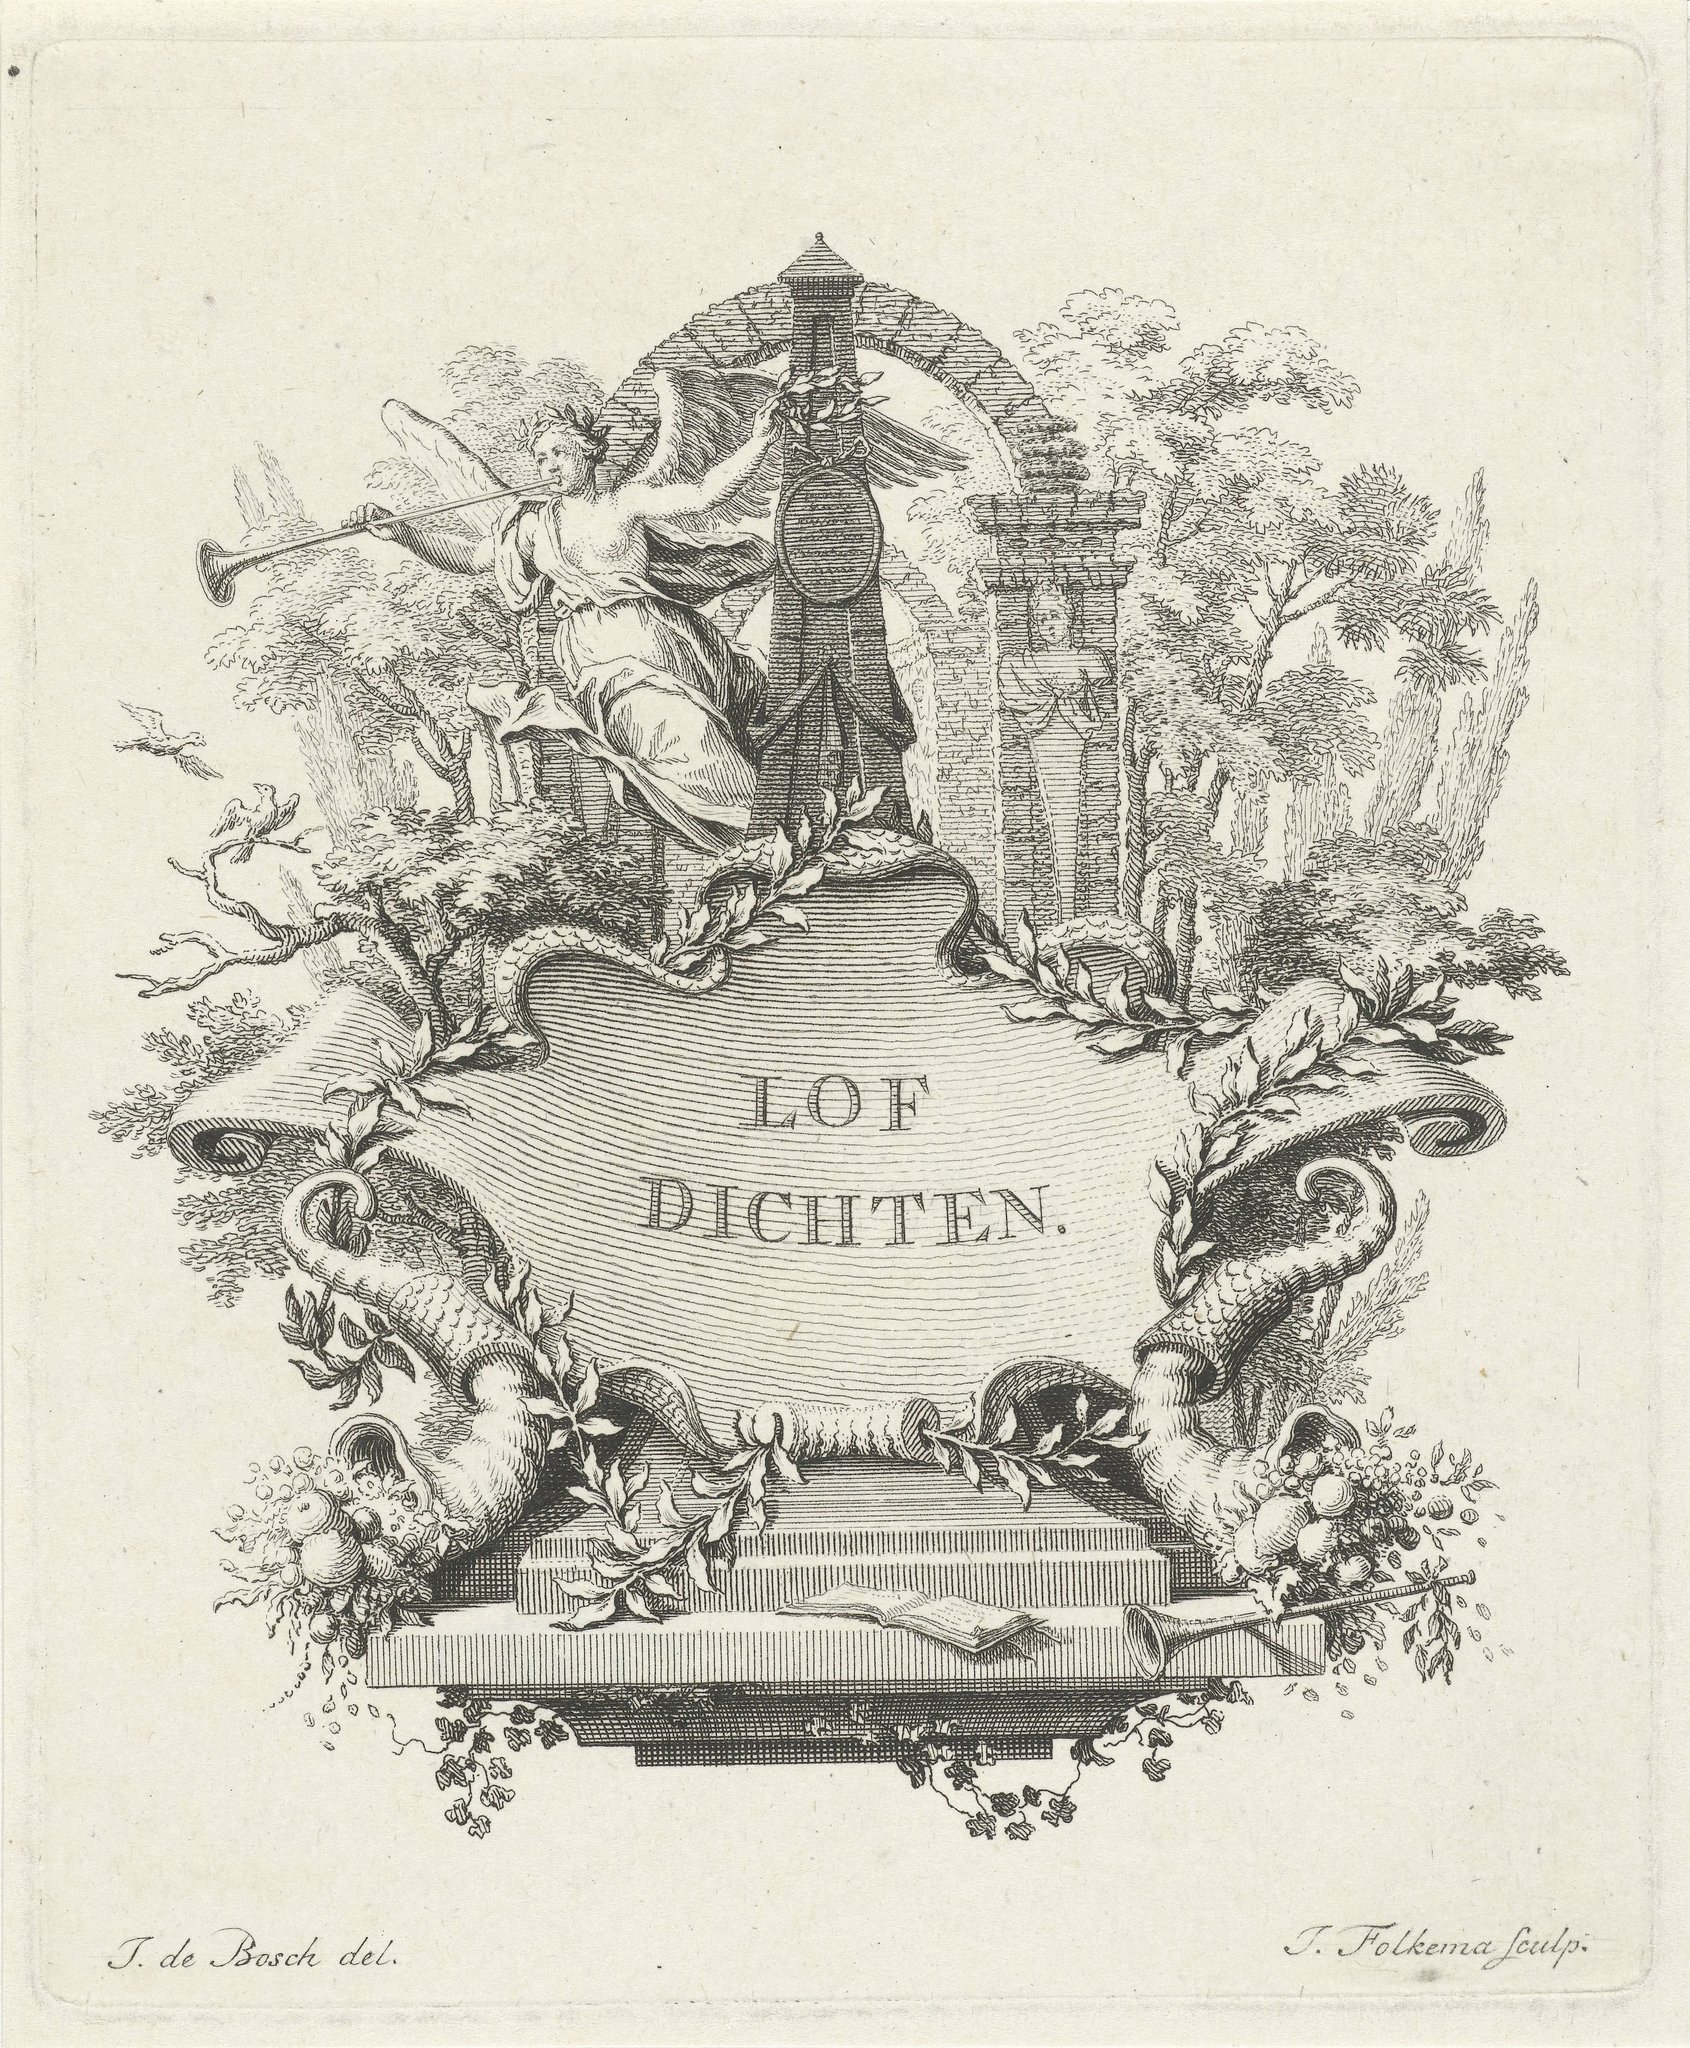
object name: print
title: Gedenkzuil met cartouche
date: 1757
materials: paper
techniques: etching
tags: 'cornucopia', horn of plenty, other memorial structures, fame; 'fama', 'fama buona', 'fama chiara' (ripa)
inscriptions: collector's mark: Lugt 2228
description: Een met bladeren versierd cartouche staat op de voet van een gedenkzuil. Op de cartouche staat de titel, links en rechts hiervan zijn met vruchten gevulde hoornen afgebeeld. Bij de top van de gedenkzuil vliegt een bazuin blazende engel met een lauwerkrans.